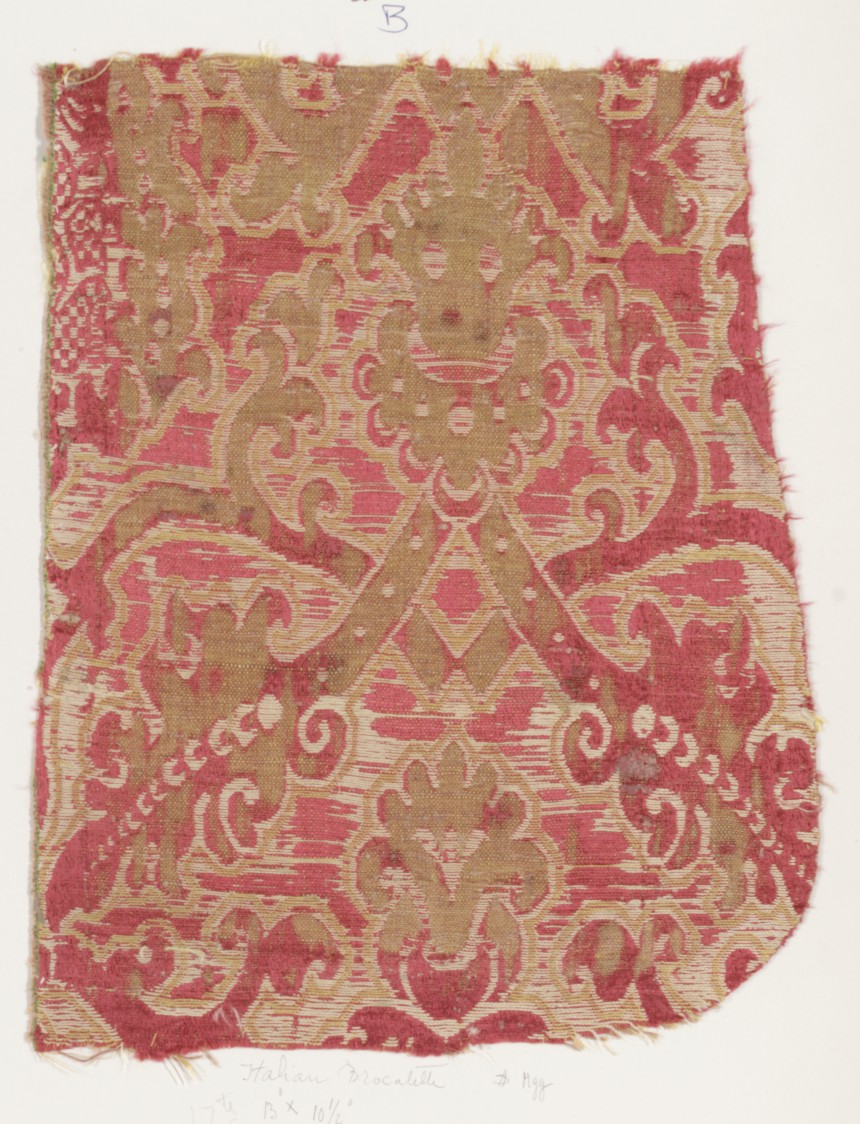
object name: fragment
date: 1601-1700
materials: silk